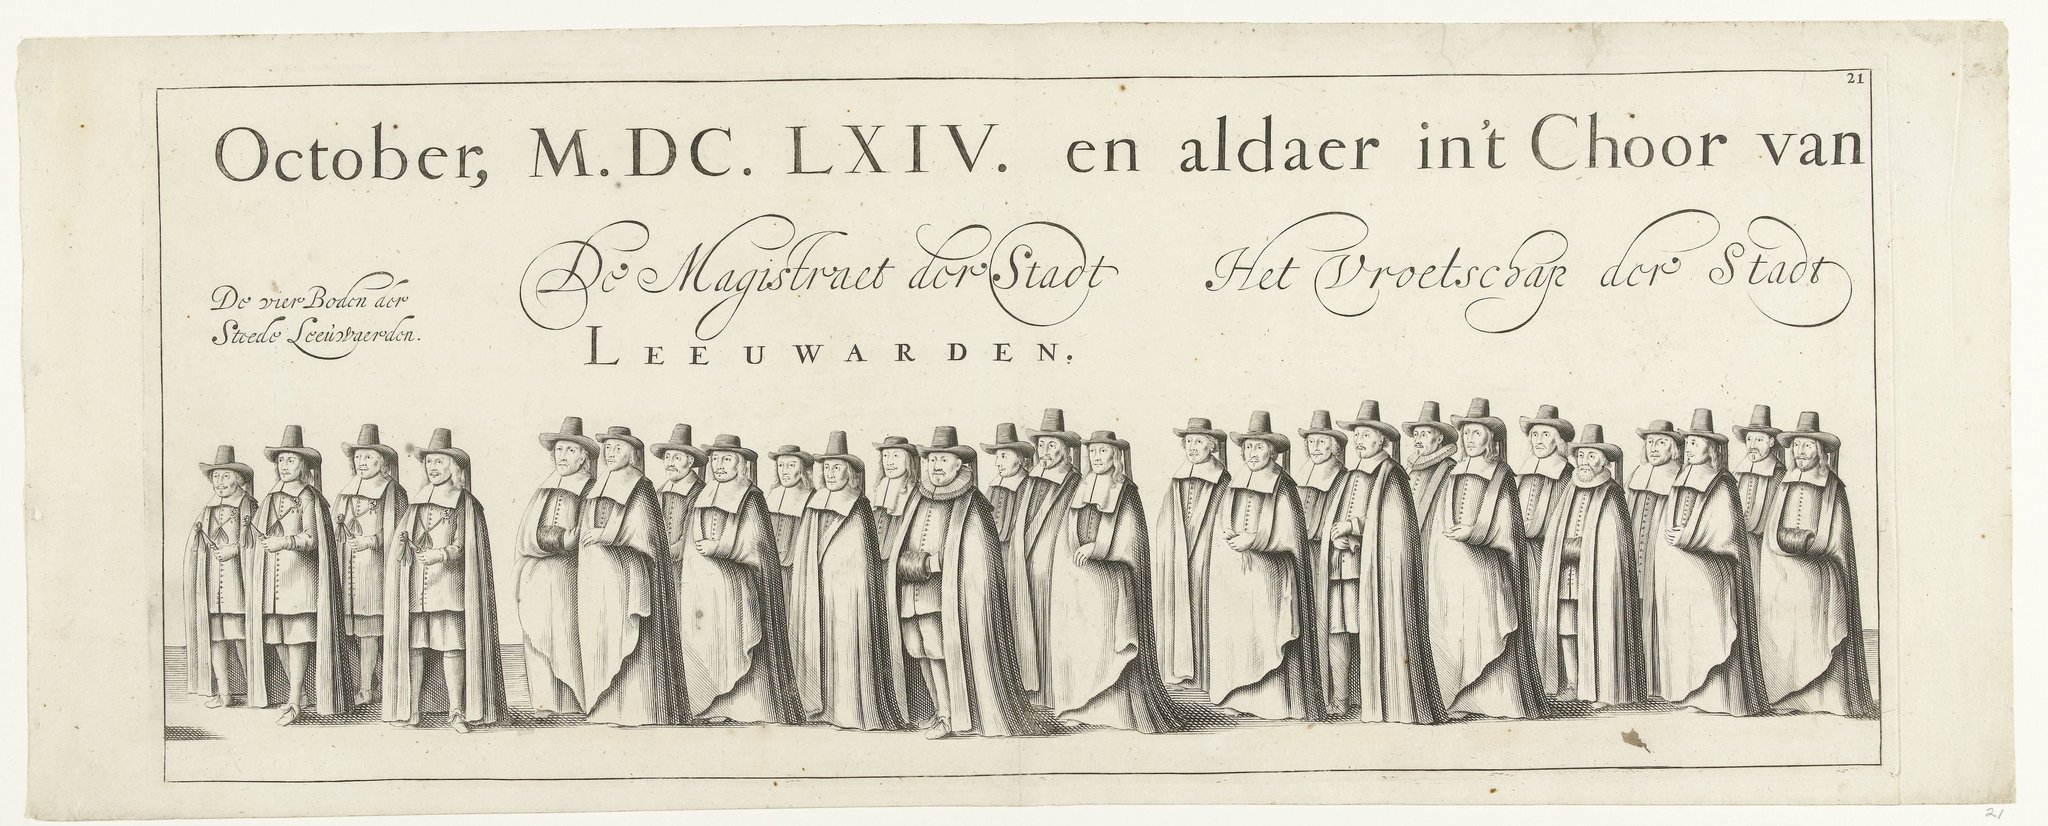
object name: print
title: Rouw-Staetelijcke Lijk-pracht in de Uyt-Vaert en Begraefenisse van het ont-zielde Lichaem van (...) Wilhelm Frederich (...) Overleden binnen Leeuwarden (...) den een-en-twintichsten October, MDCLXIV. en aldaer in 't Choor van de Jacobijner Kerck, den vyfthienden december MDCLXIV. Oude Stijl (...)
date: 1666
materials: paper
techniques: engraving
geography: leeuwarden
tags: arnhem, cortege, funeral procession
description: Begrafenisoptocht van Willem Frederik, graaf van Nassau-Dietz, in Leeuwarden op 6 januari 1665. Deel van de begrafenisstoet. Plaat nr. 21 in een ensemble van 25 ongemonteerde genummerde platen en twee tekstbladen die samen een lange fries vormen.